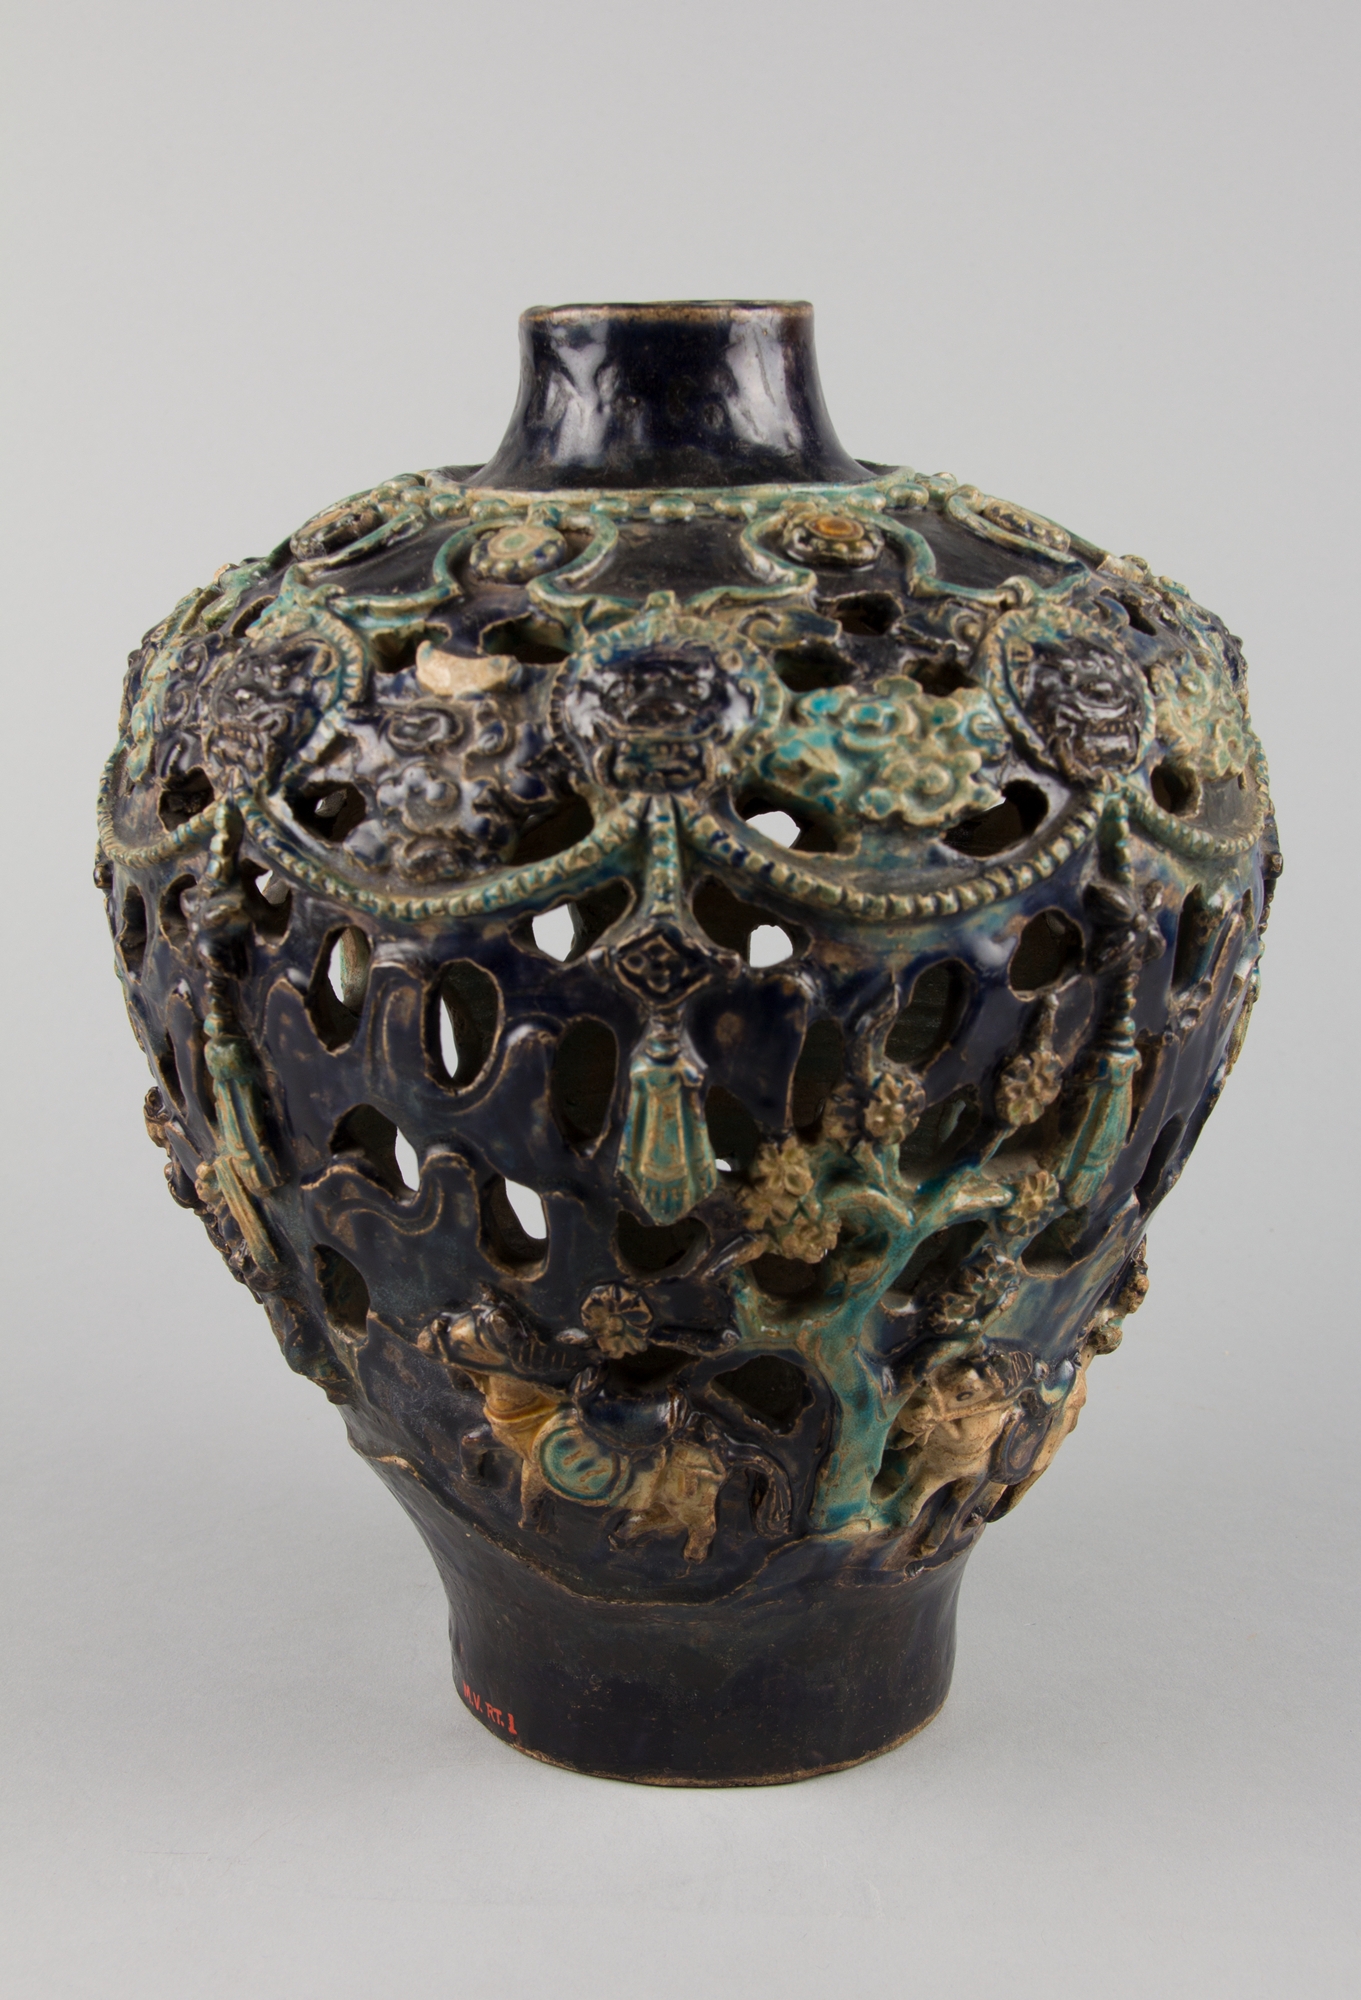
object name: vase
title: Vase with figural scene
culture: chinese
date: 1501-1600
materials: enamel, stoneware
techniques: painting, polychrome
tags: horses